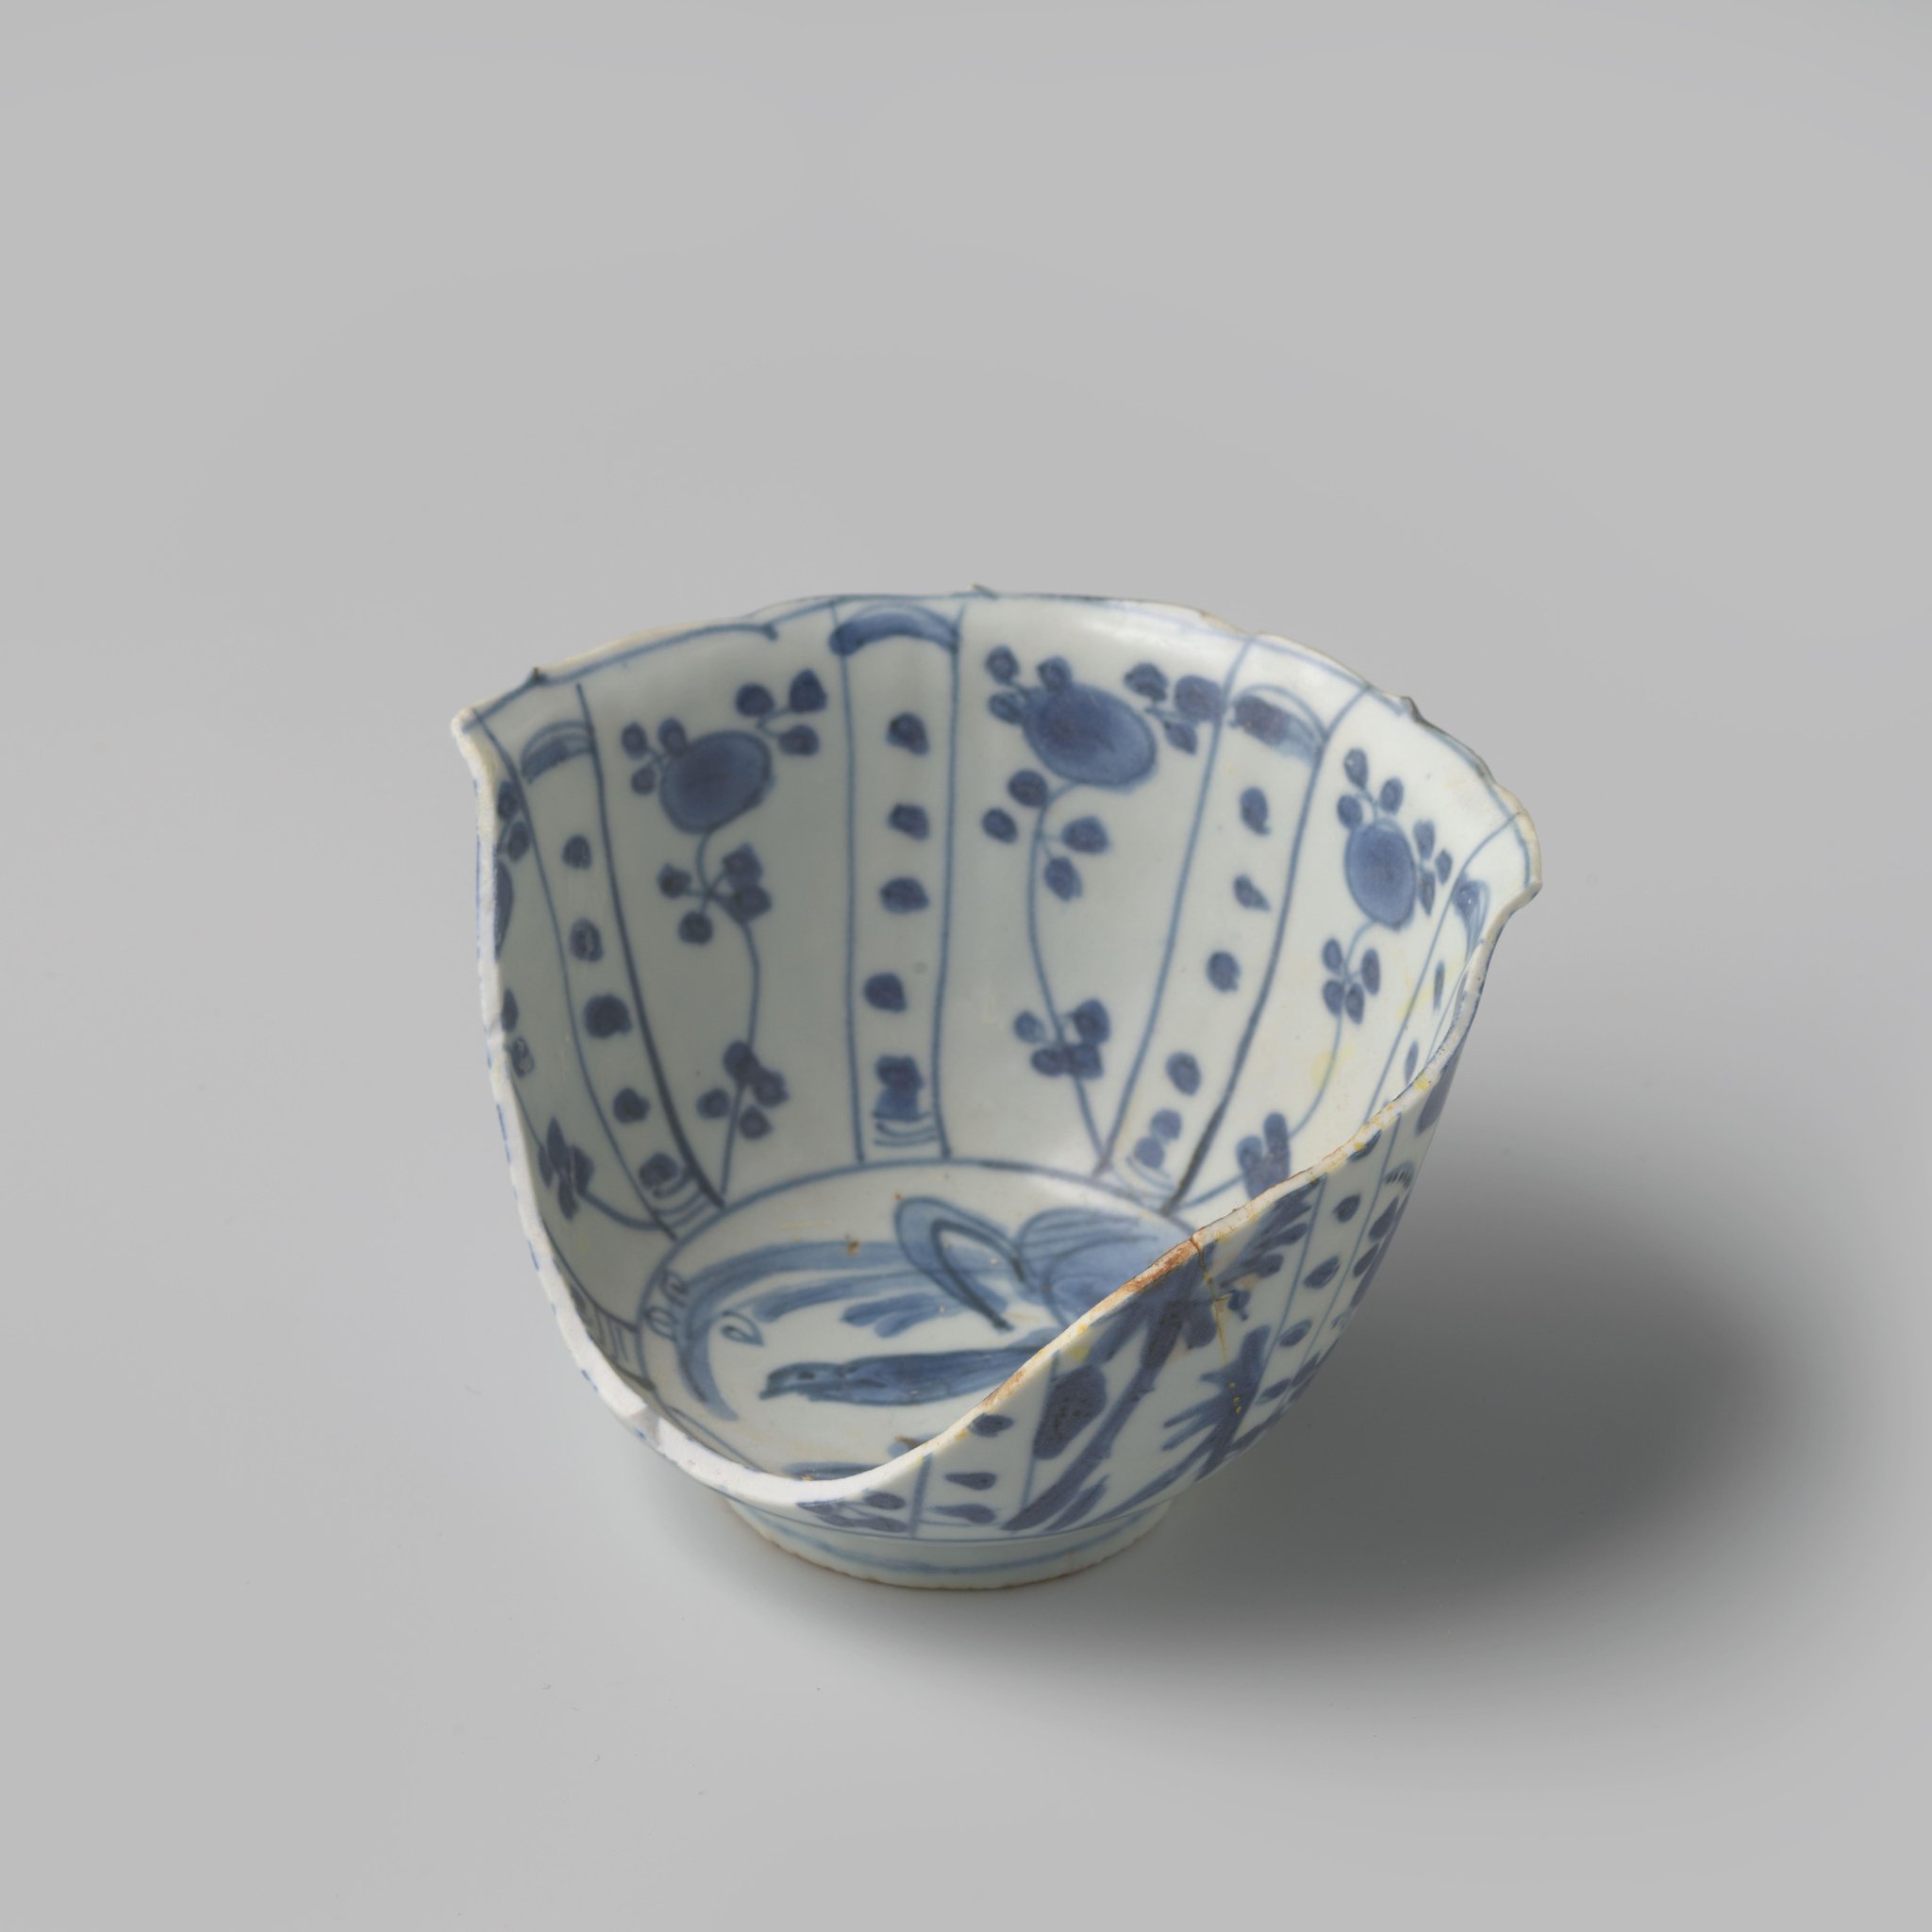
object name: bowl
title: Scherven van een kom uit V.O.C.-schip de 'Witte Leeuw'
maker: Anonymous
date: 1613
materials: bone china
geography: jingdezhen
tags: verenigde oostindische compagnie, sint-helena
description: A dish without a flattened rim. An eight-sided thickly drawn medallion. A central decoration of a bird on a rock and a lotusplant in a marsh landscape. The medallions decorated with flowers, peaches and symbols.